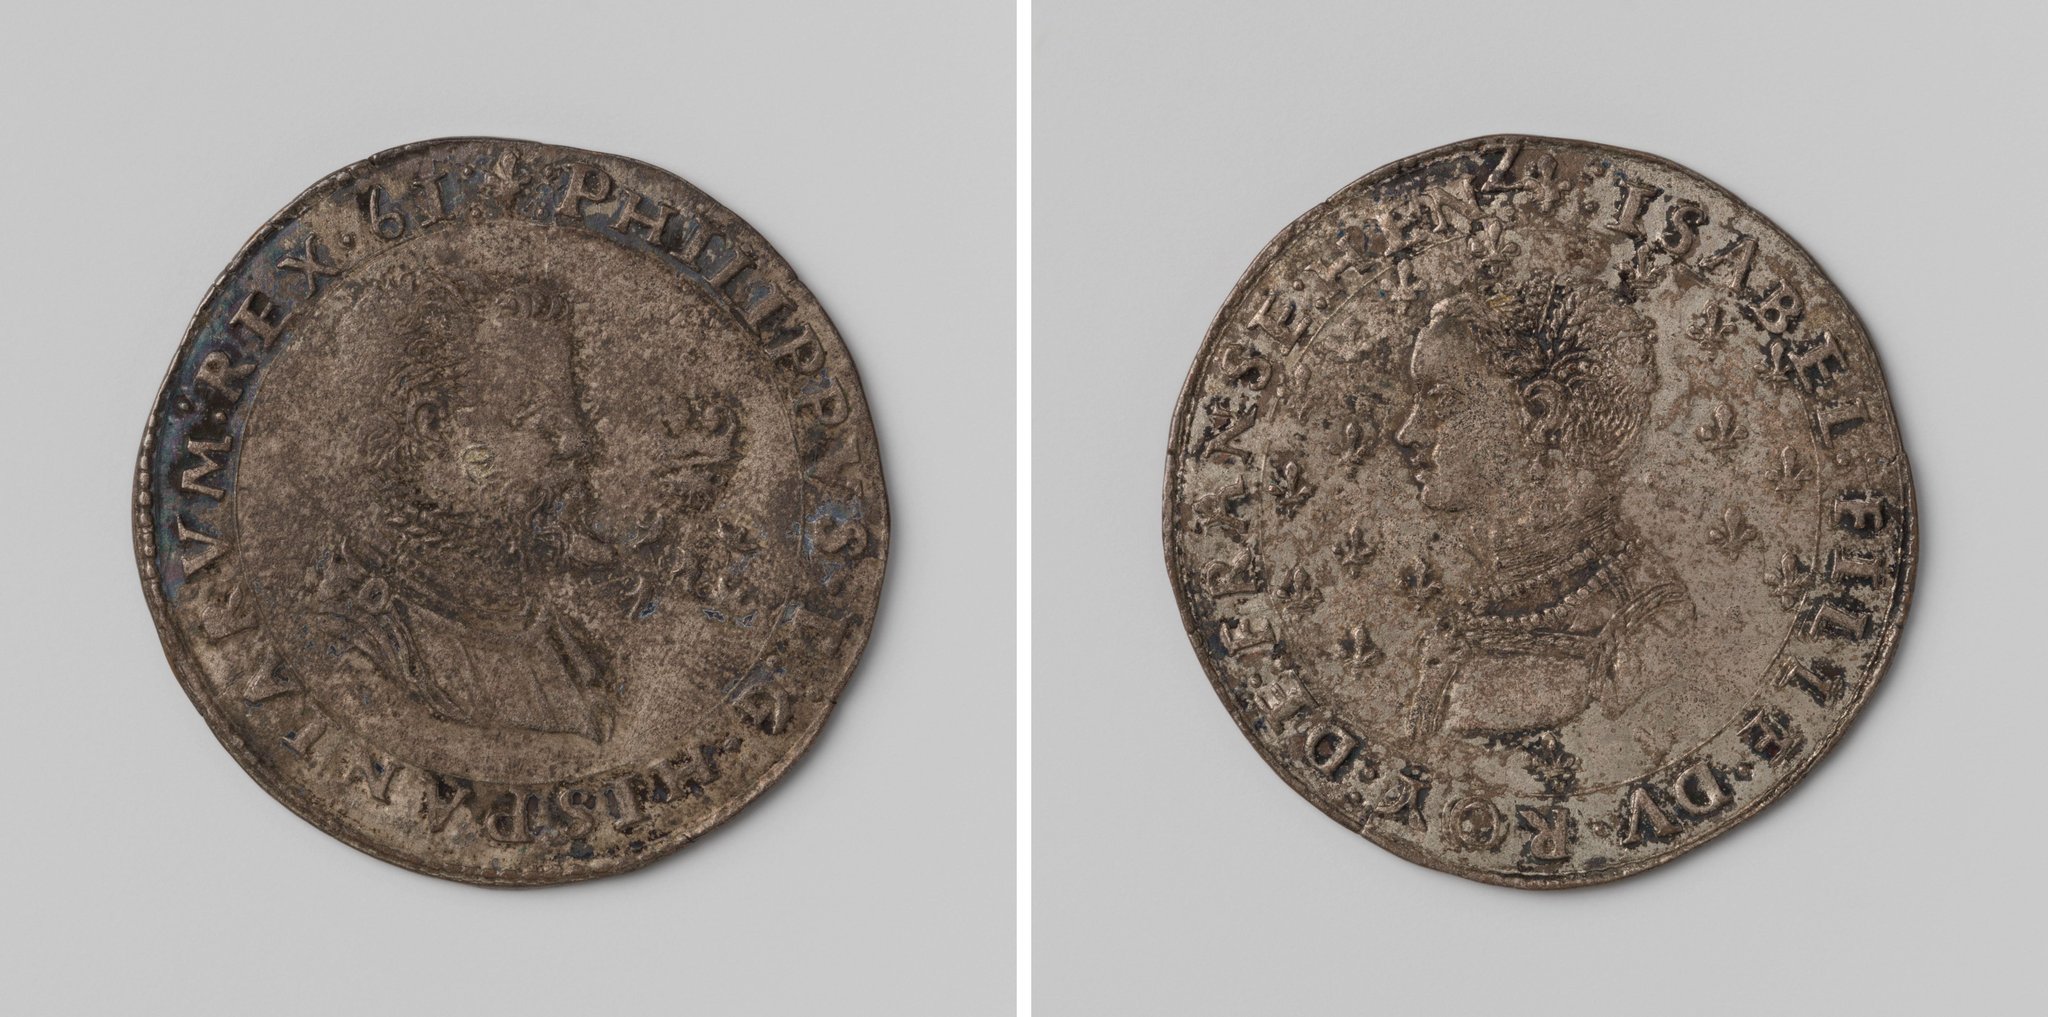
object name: jeton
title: Filips II en Isabella, koning en koningin van Spanje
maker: Anonymous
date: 1561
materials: silver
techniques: striking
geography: wallonia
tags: philip ii of spain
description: Zilveren penning. Voorzijde: borststuk man; rechts: vuurslag, waar vonken uitschieten binnen omschrift. Keerzijde: borststuk vrouw op veld, bezaaid met lelies binnen omschrift